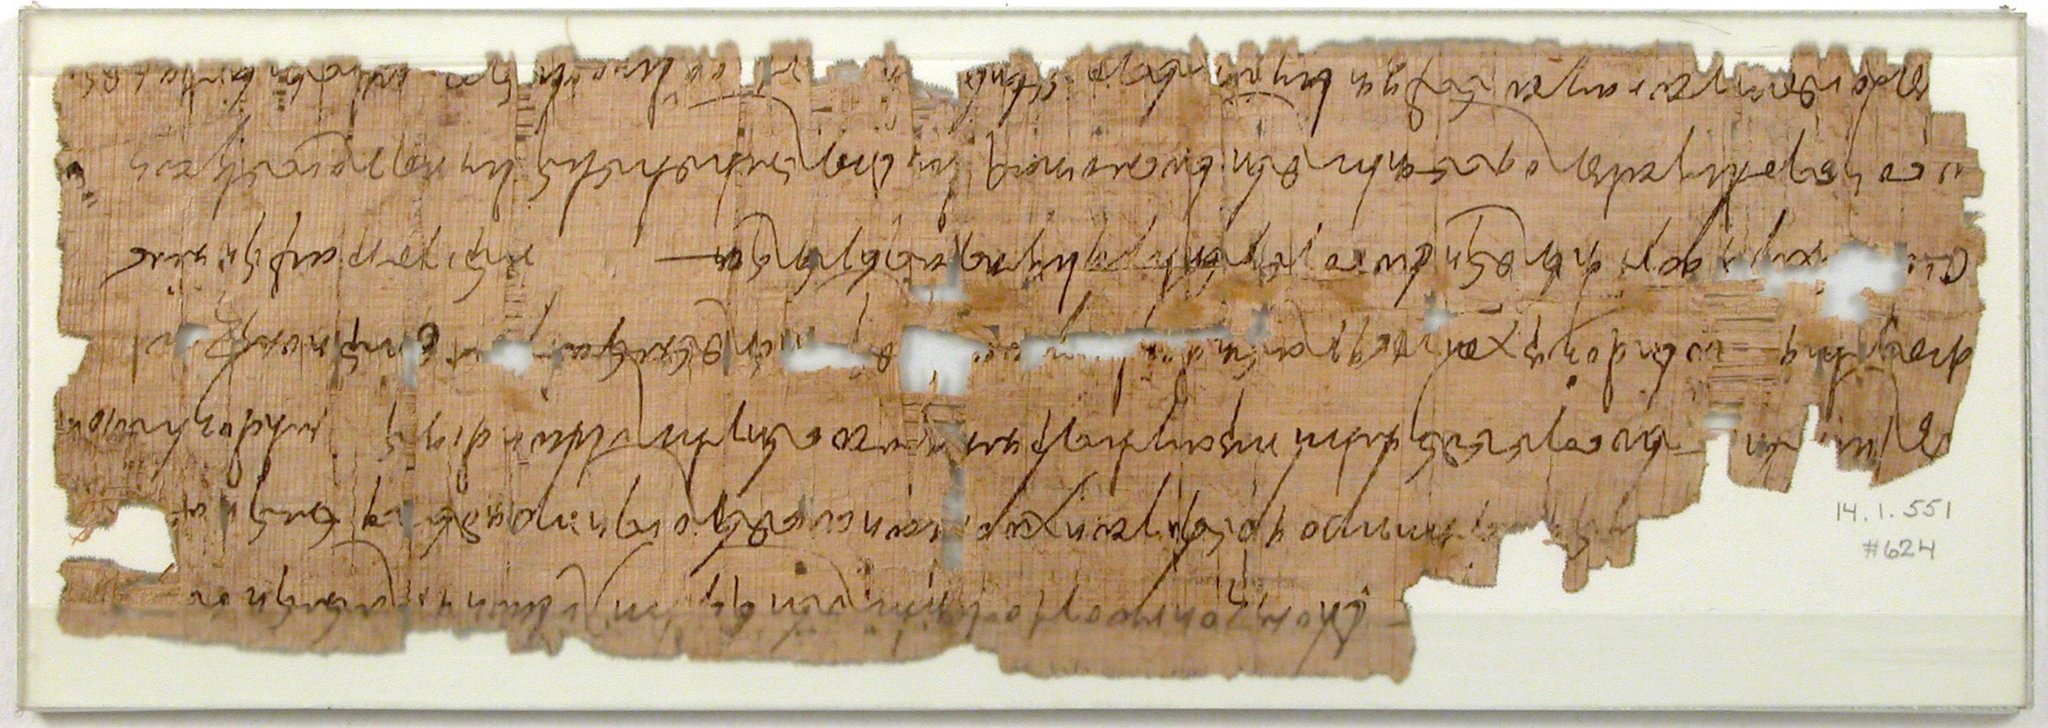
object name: fragment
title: Papyrus Fragment of a Letter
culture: coptic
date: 580-640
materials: ink, papyrus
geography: egypt